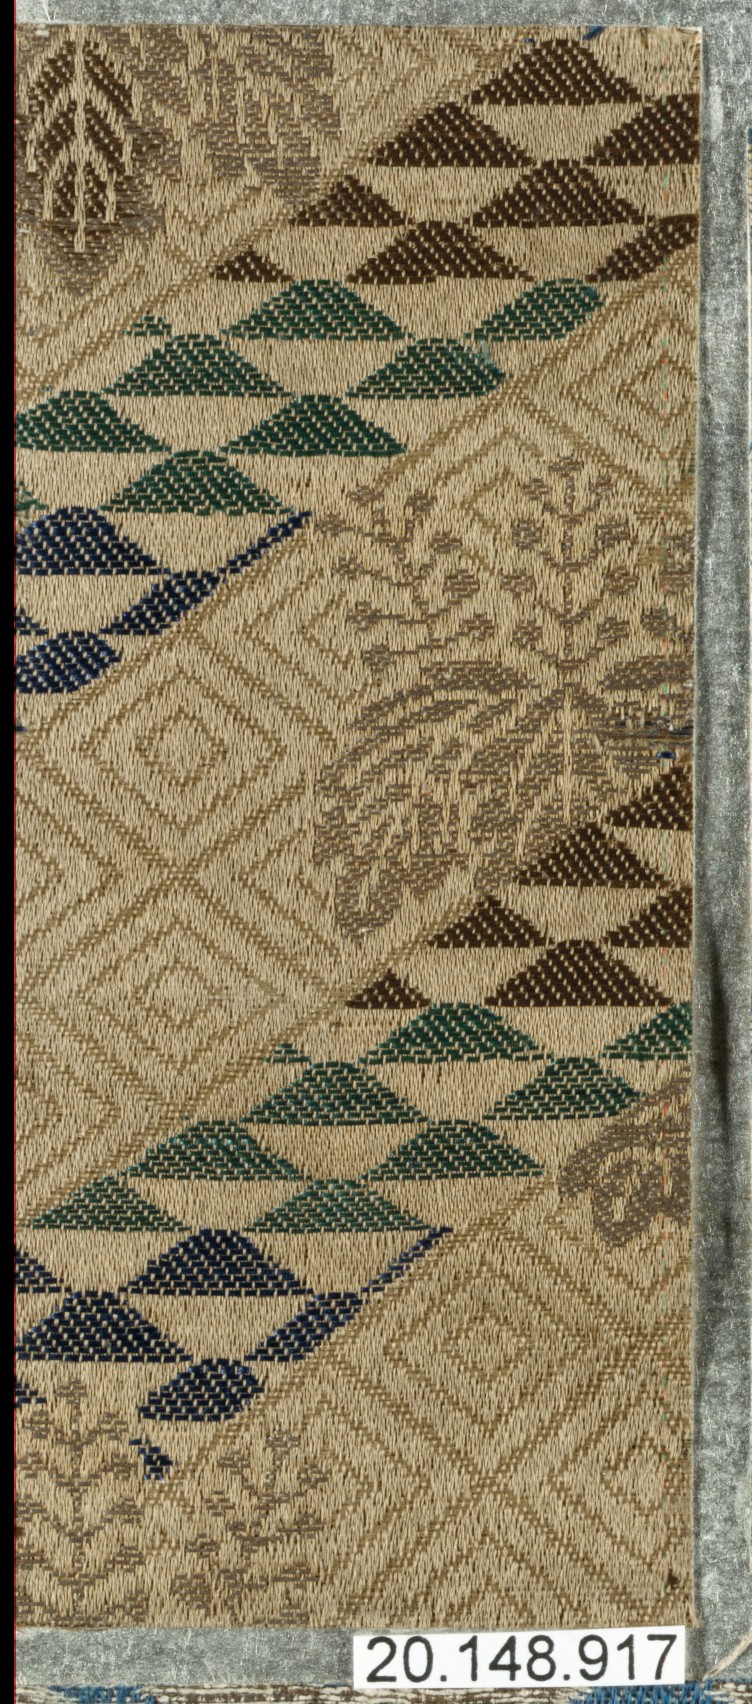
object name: piece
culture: japanese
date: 1601-1700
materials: silk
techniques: compound weave